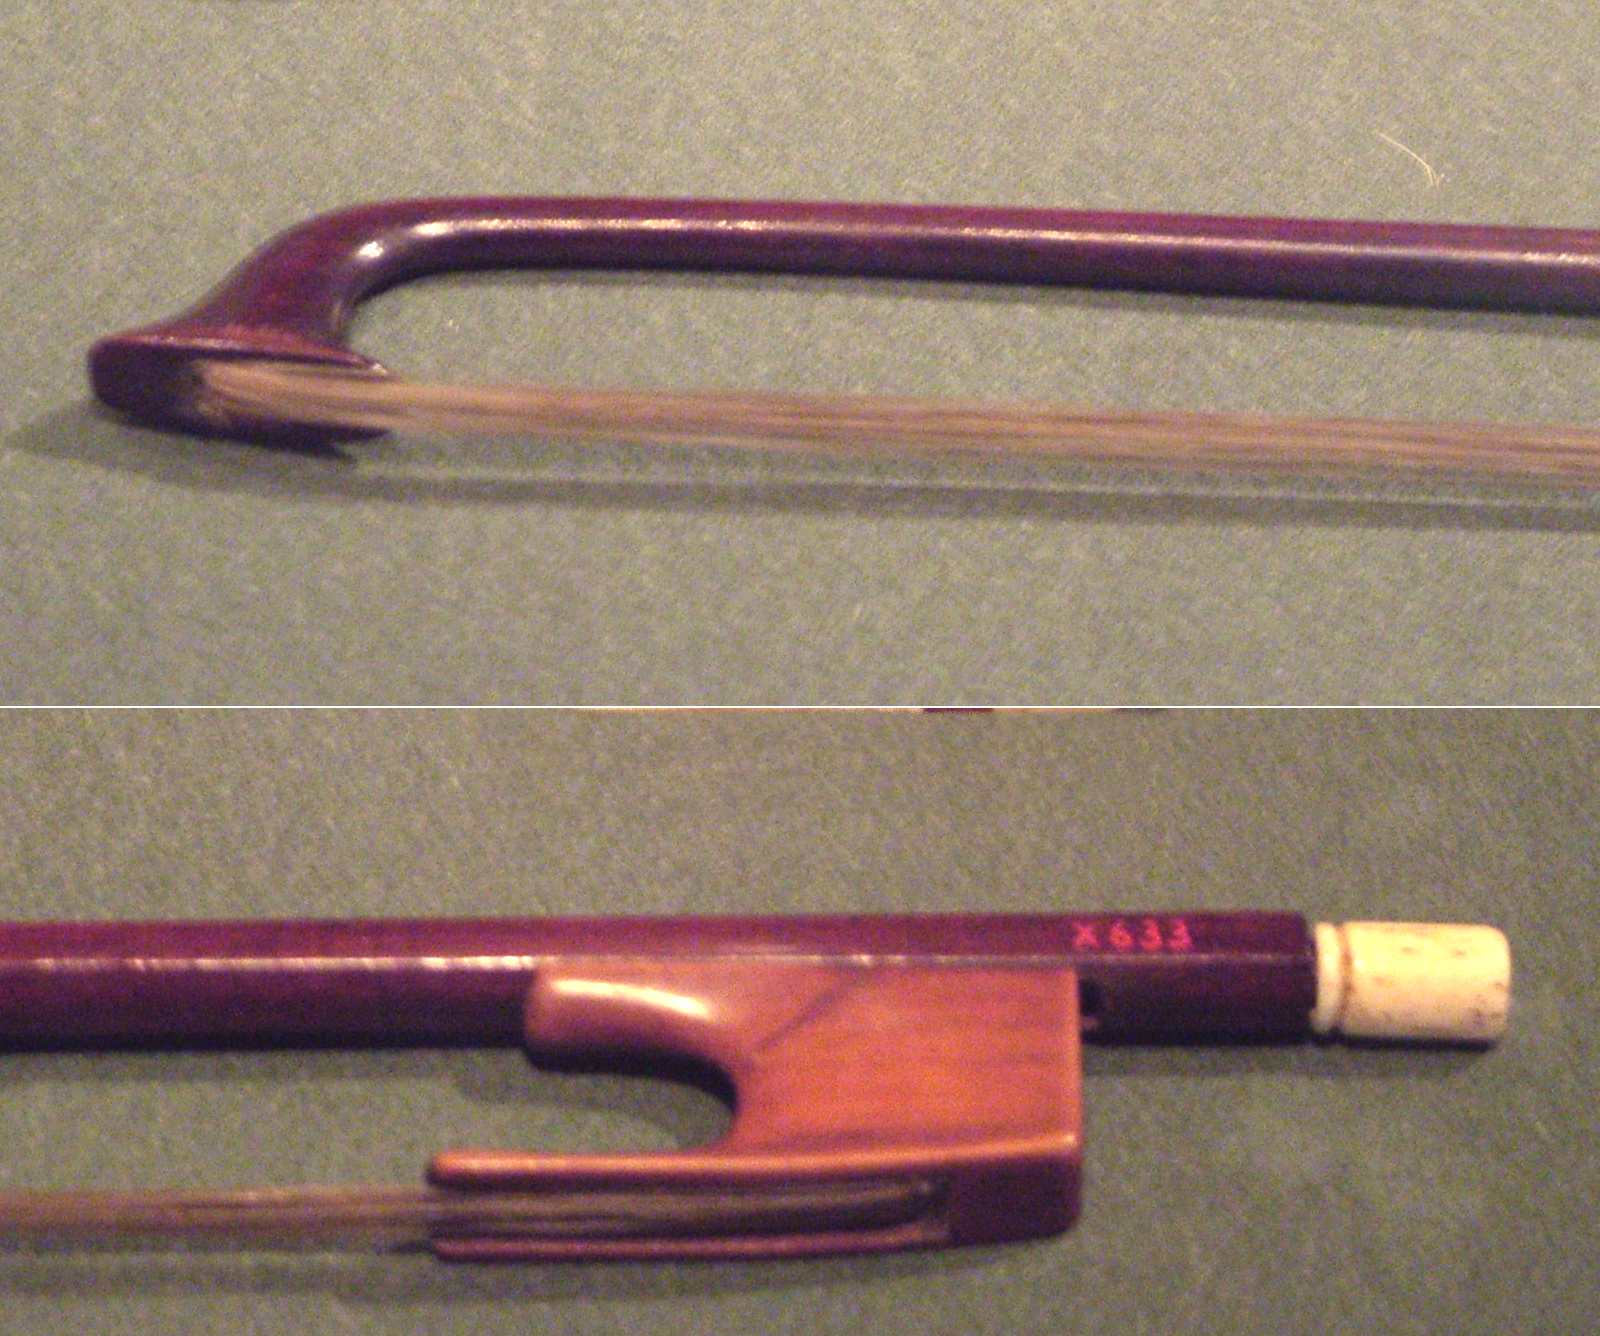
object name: violin bow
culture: french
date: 1734-1766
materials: hair, ivory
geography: france